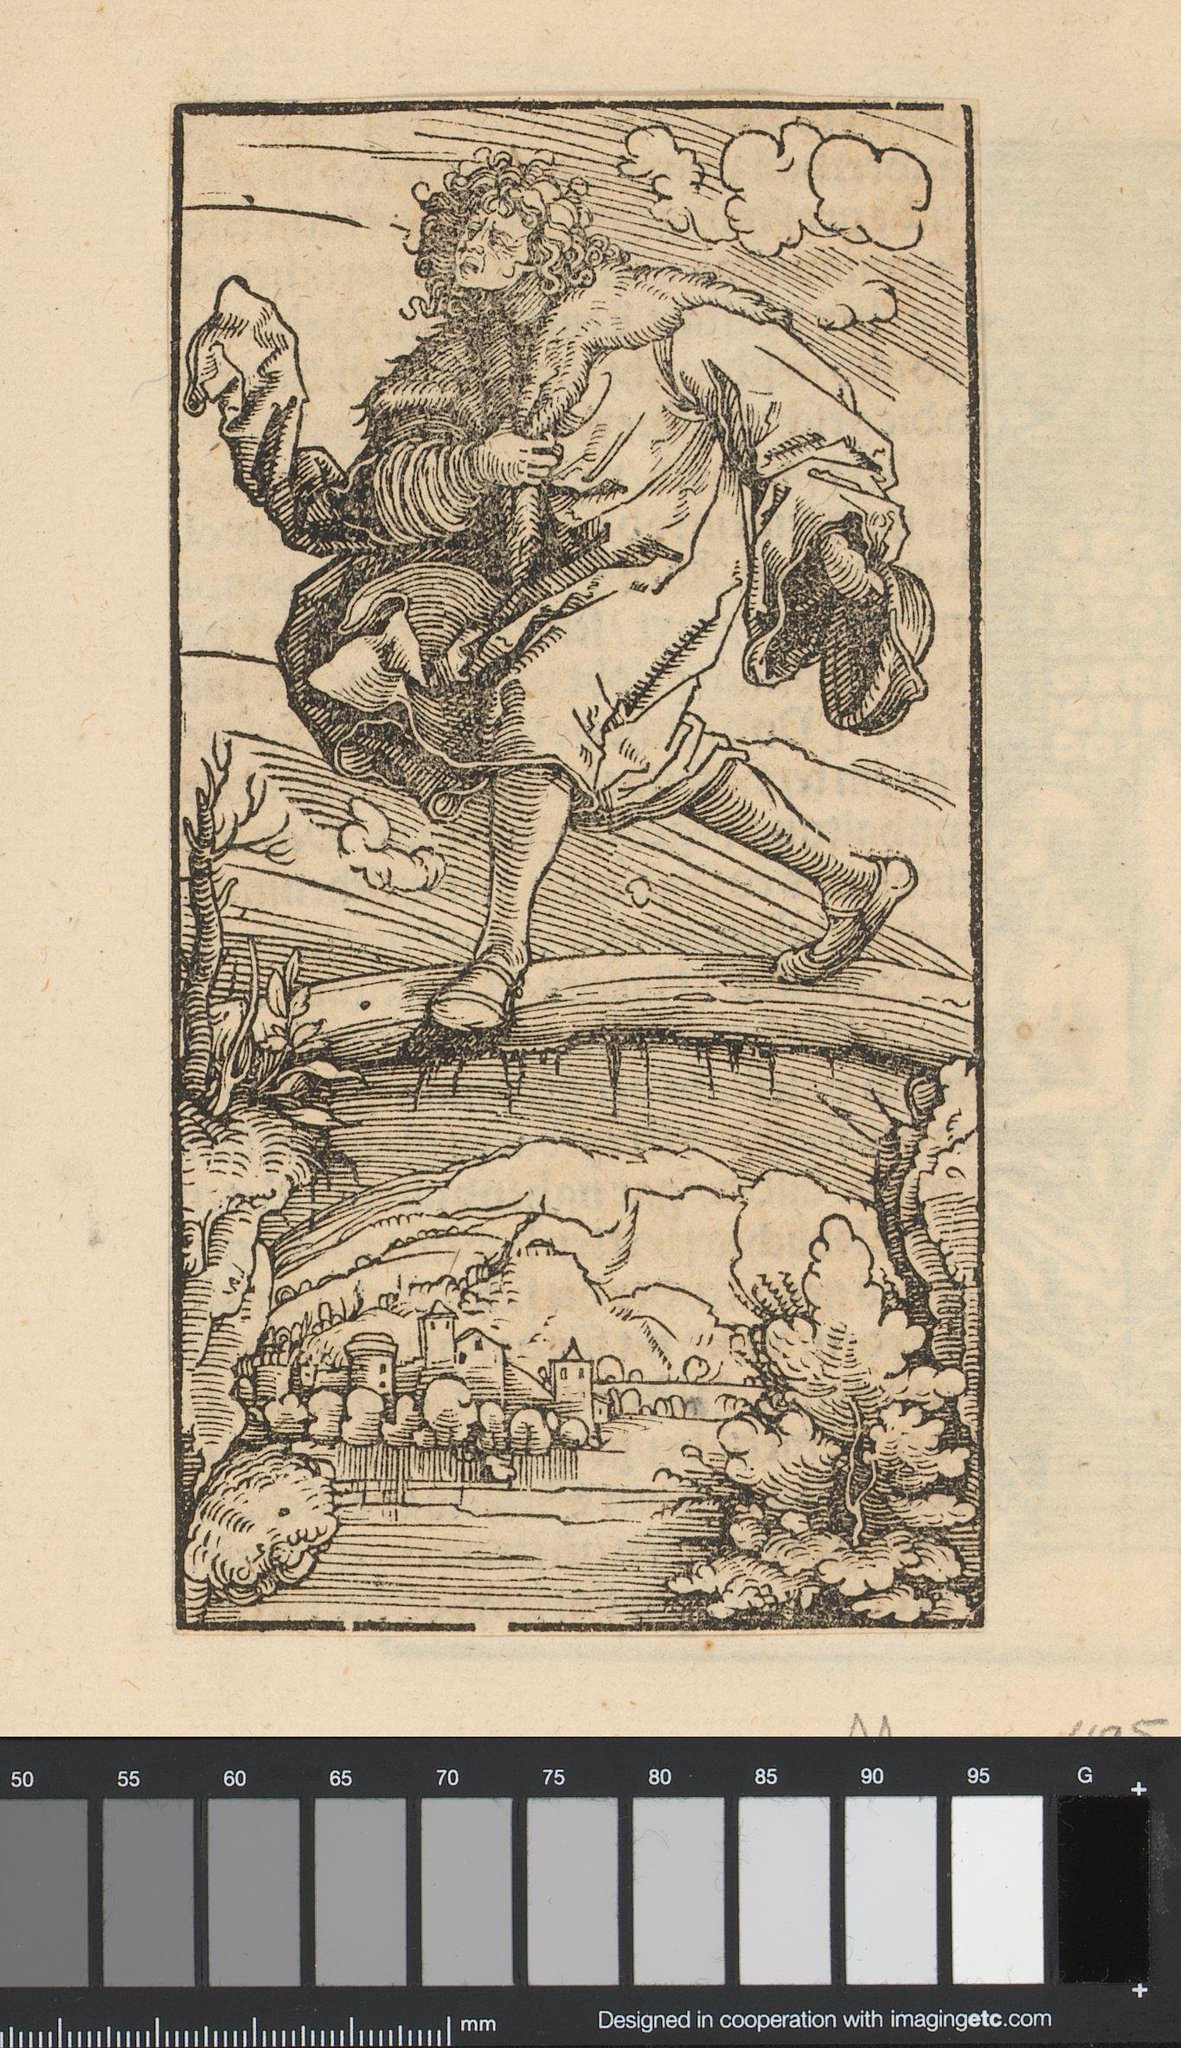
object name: album leaf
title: Pelgrim loopt over een brug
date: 1514-1531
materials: paper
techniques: letterpress printing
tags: pilgrimage, pilgrim(s) under way, bridge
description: Deze prent is gebruikt in: Cicero, Marcus Tulius. Officia M.T.C. Ein Buch so Marcus Tullius Cicero der Römer zu seynem (...). [Vertaald uit het Latijn door] Johann von Schwarzenberg. Augsburg: Heinrich Steiner, 1531.